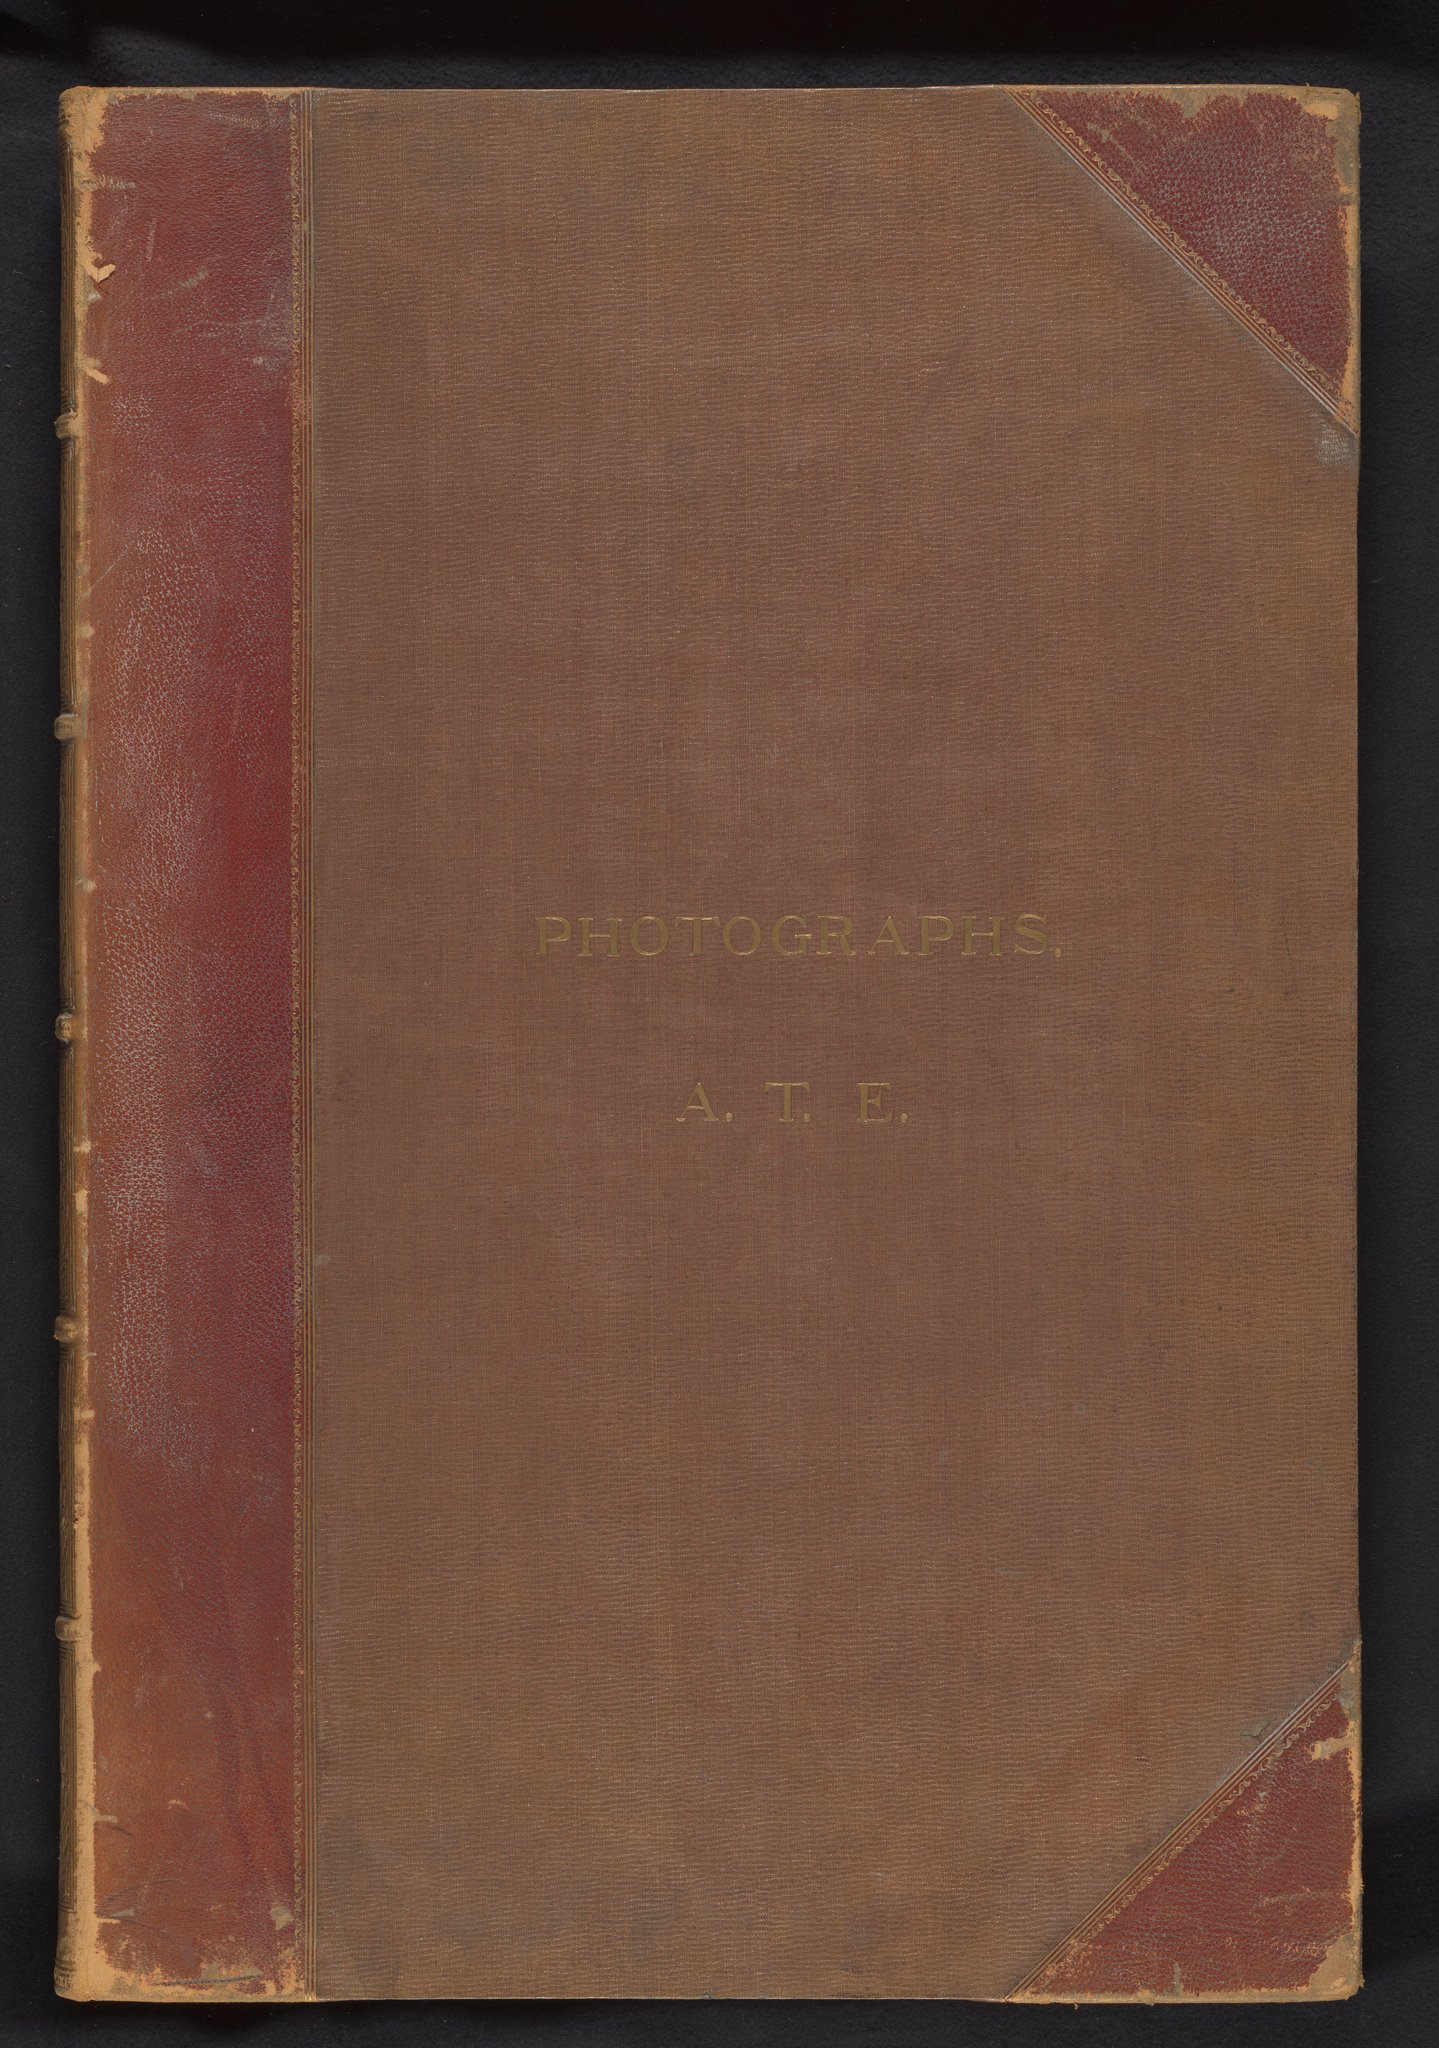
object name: book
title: Photographs A.T.E.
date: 1858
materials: cardboard, leather, linen, paper, photographic support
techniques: albumen print, printing, marbled paper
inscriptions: bookplate: ‘EIN DOE AND SPARE NOT./ Henry R. Greg.’, date: ‘MAR 1988’